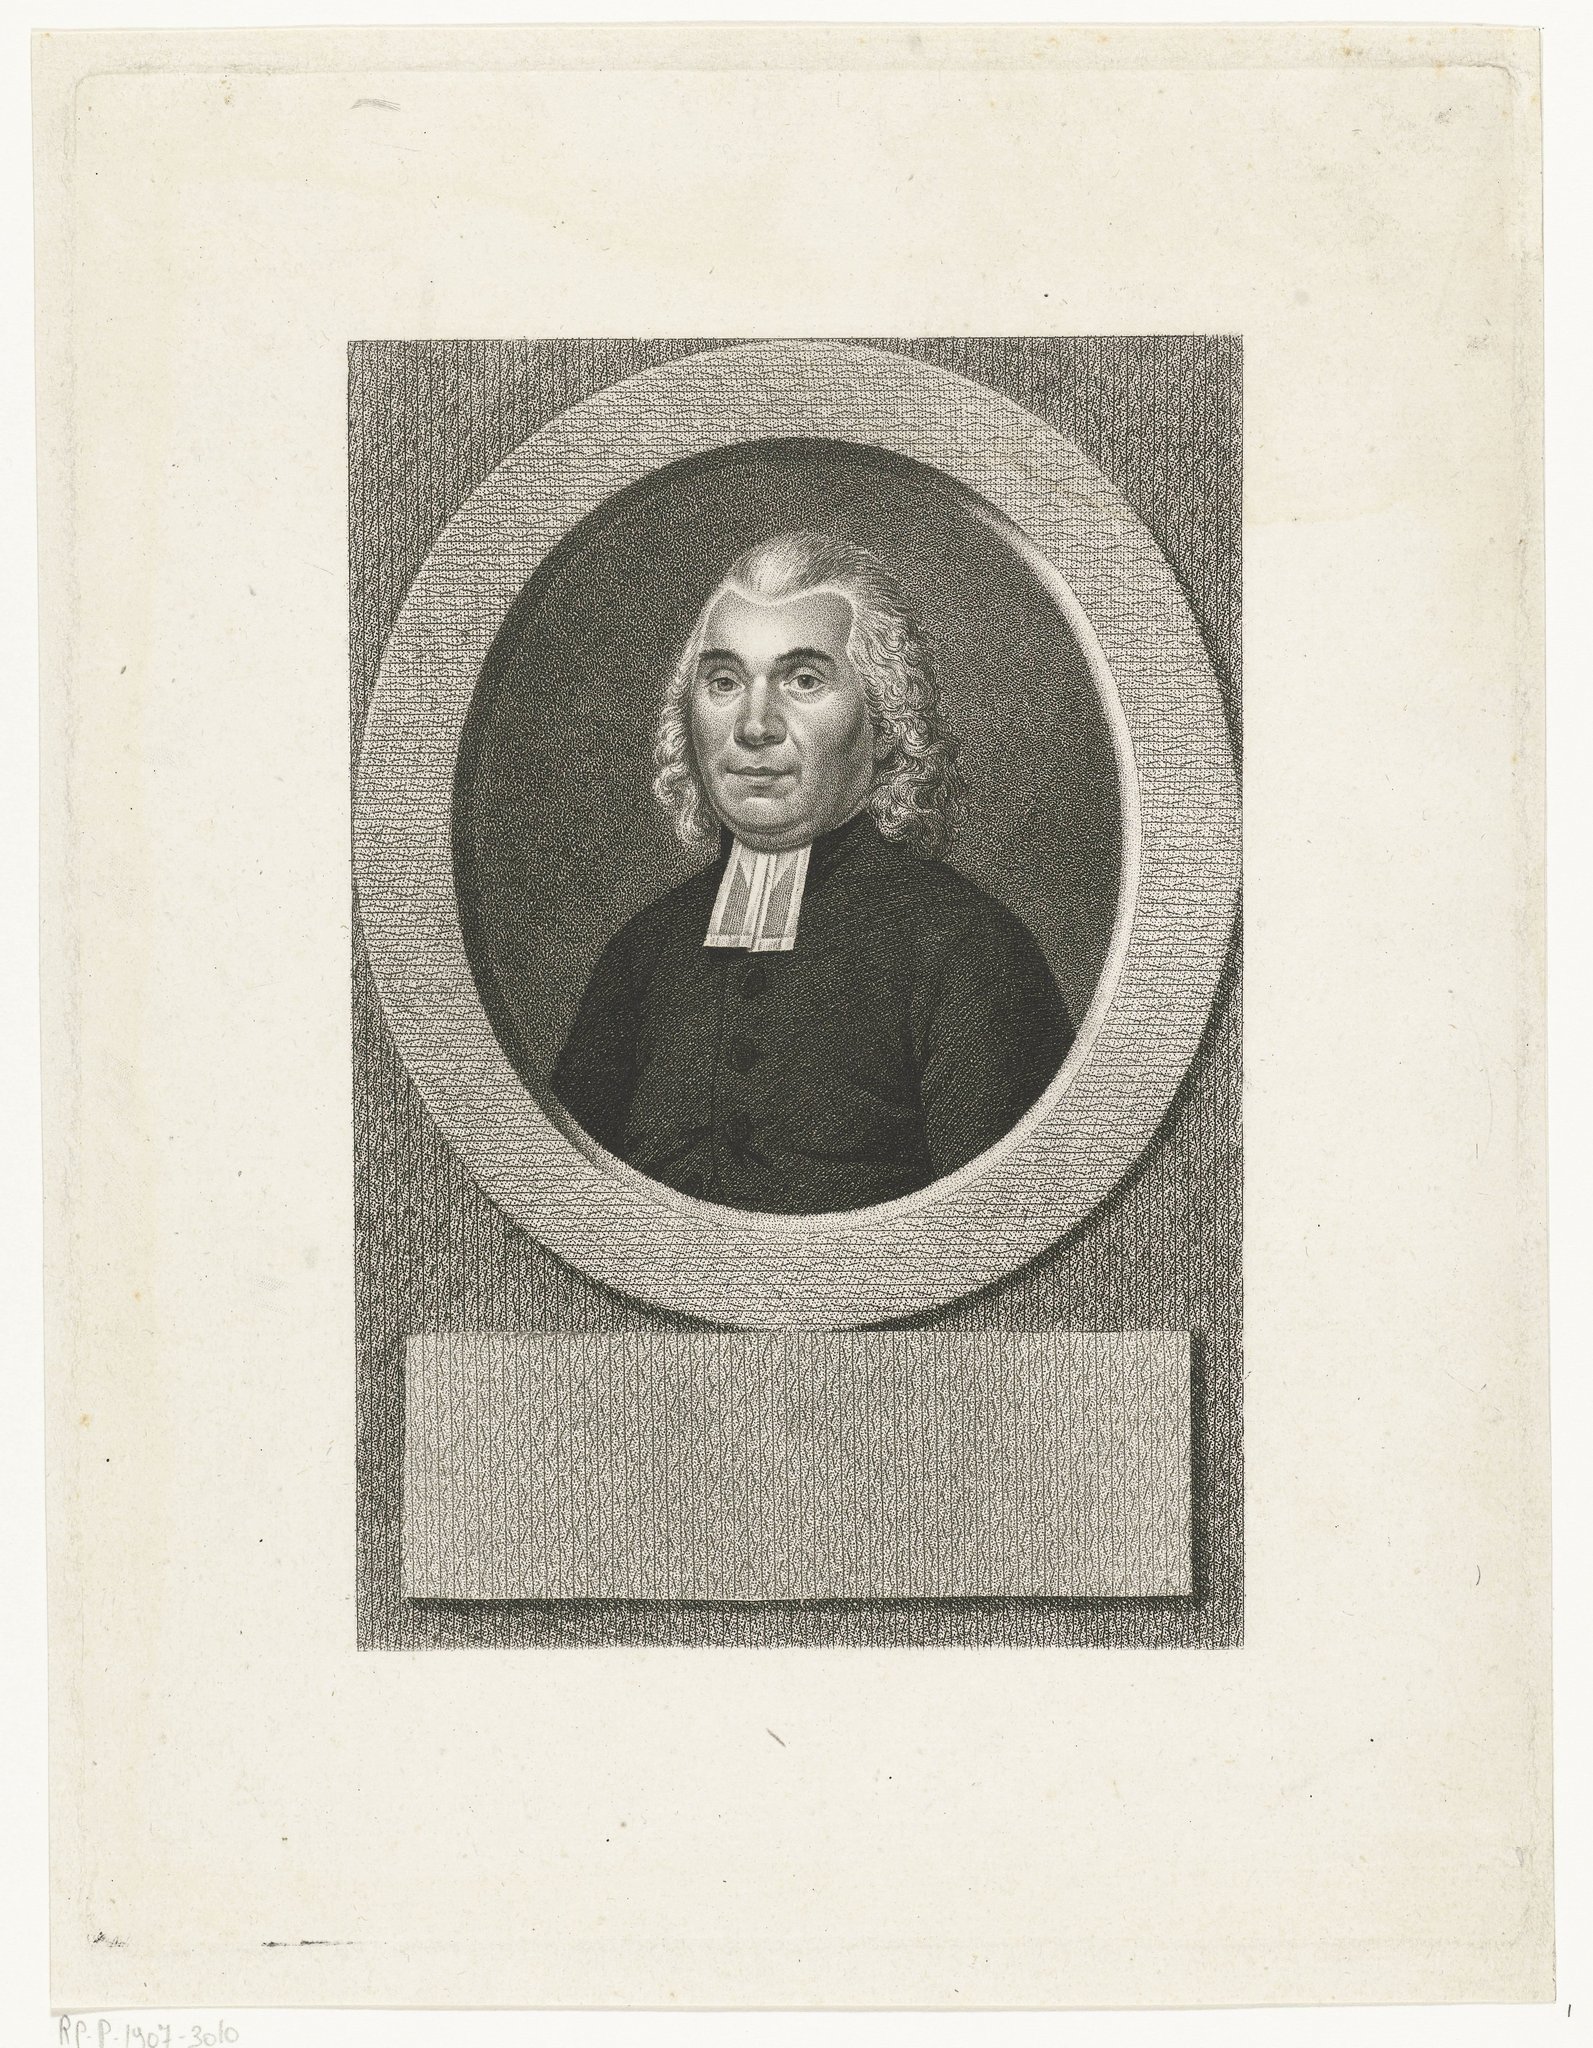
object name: print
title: Portret van Cornelis Fortuyn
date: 1803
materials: paper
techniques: etching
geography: amsterdam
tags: prediker, cornelis fortuyn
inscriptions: collector's mark: Lugt 2228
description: Portret in ovale lijst van Cornelis Fortuyn, een Amsterdamse prediker. Buste naar links. Fortuyn draagt een predikersgewaad. De prent heeft een Nederlands onderschrift met de naam van de geportretteerde.